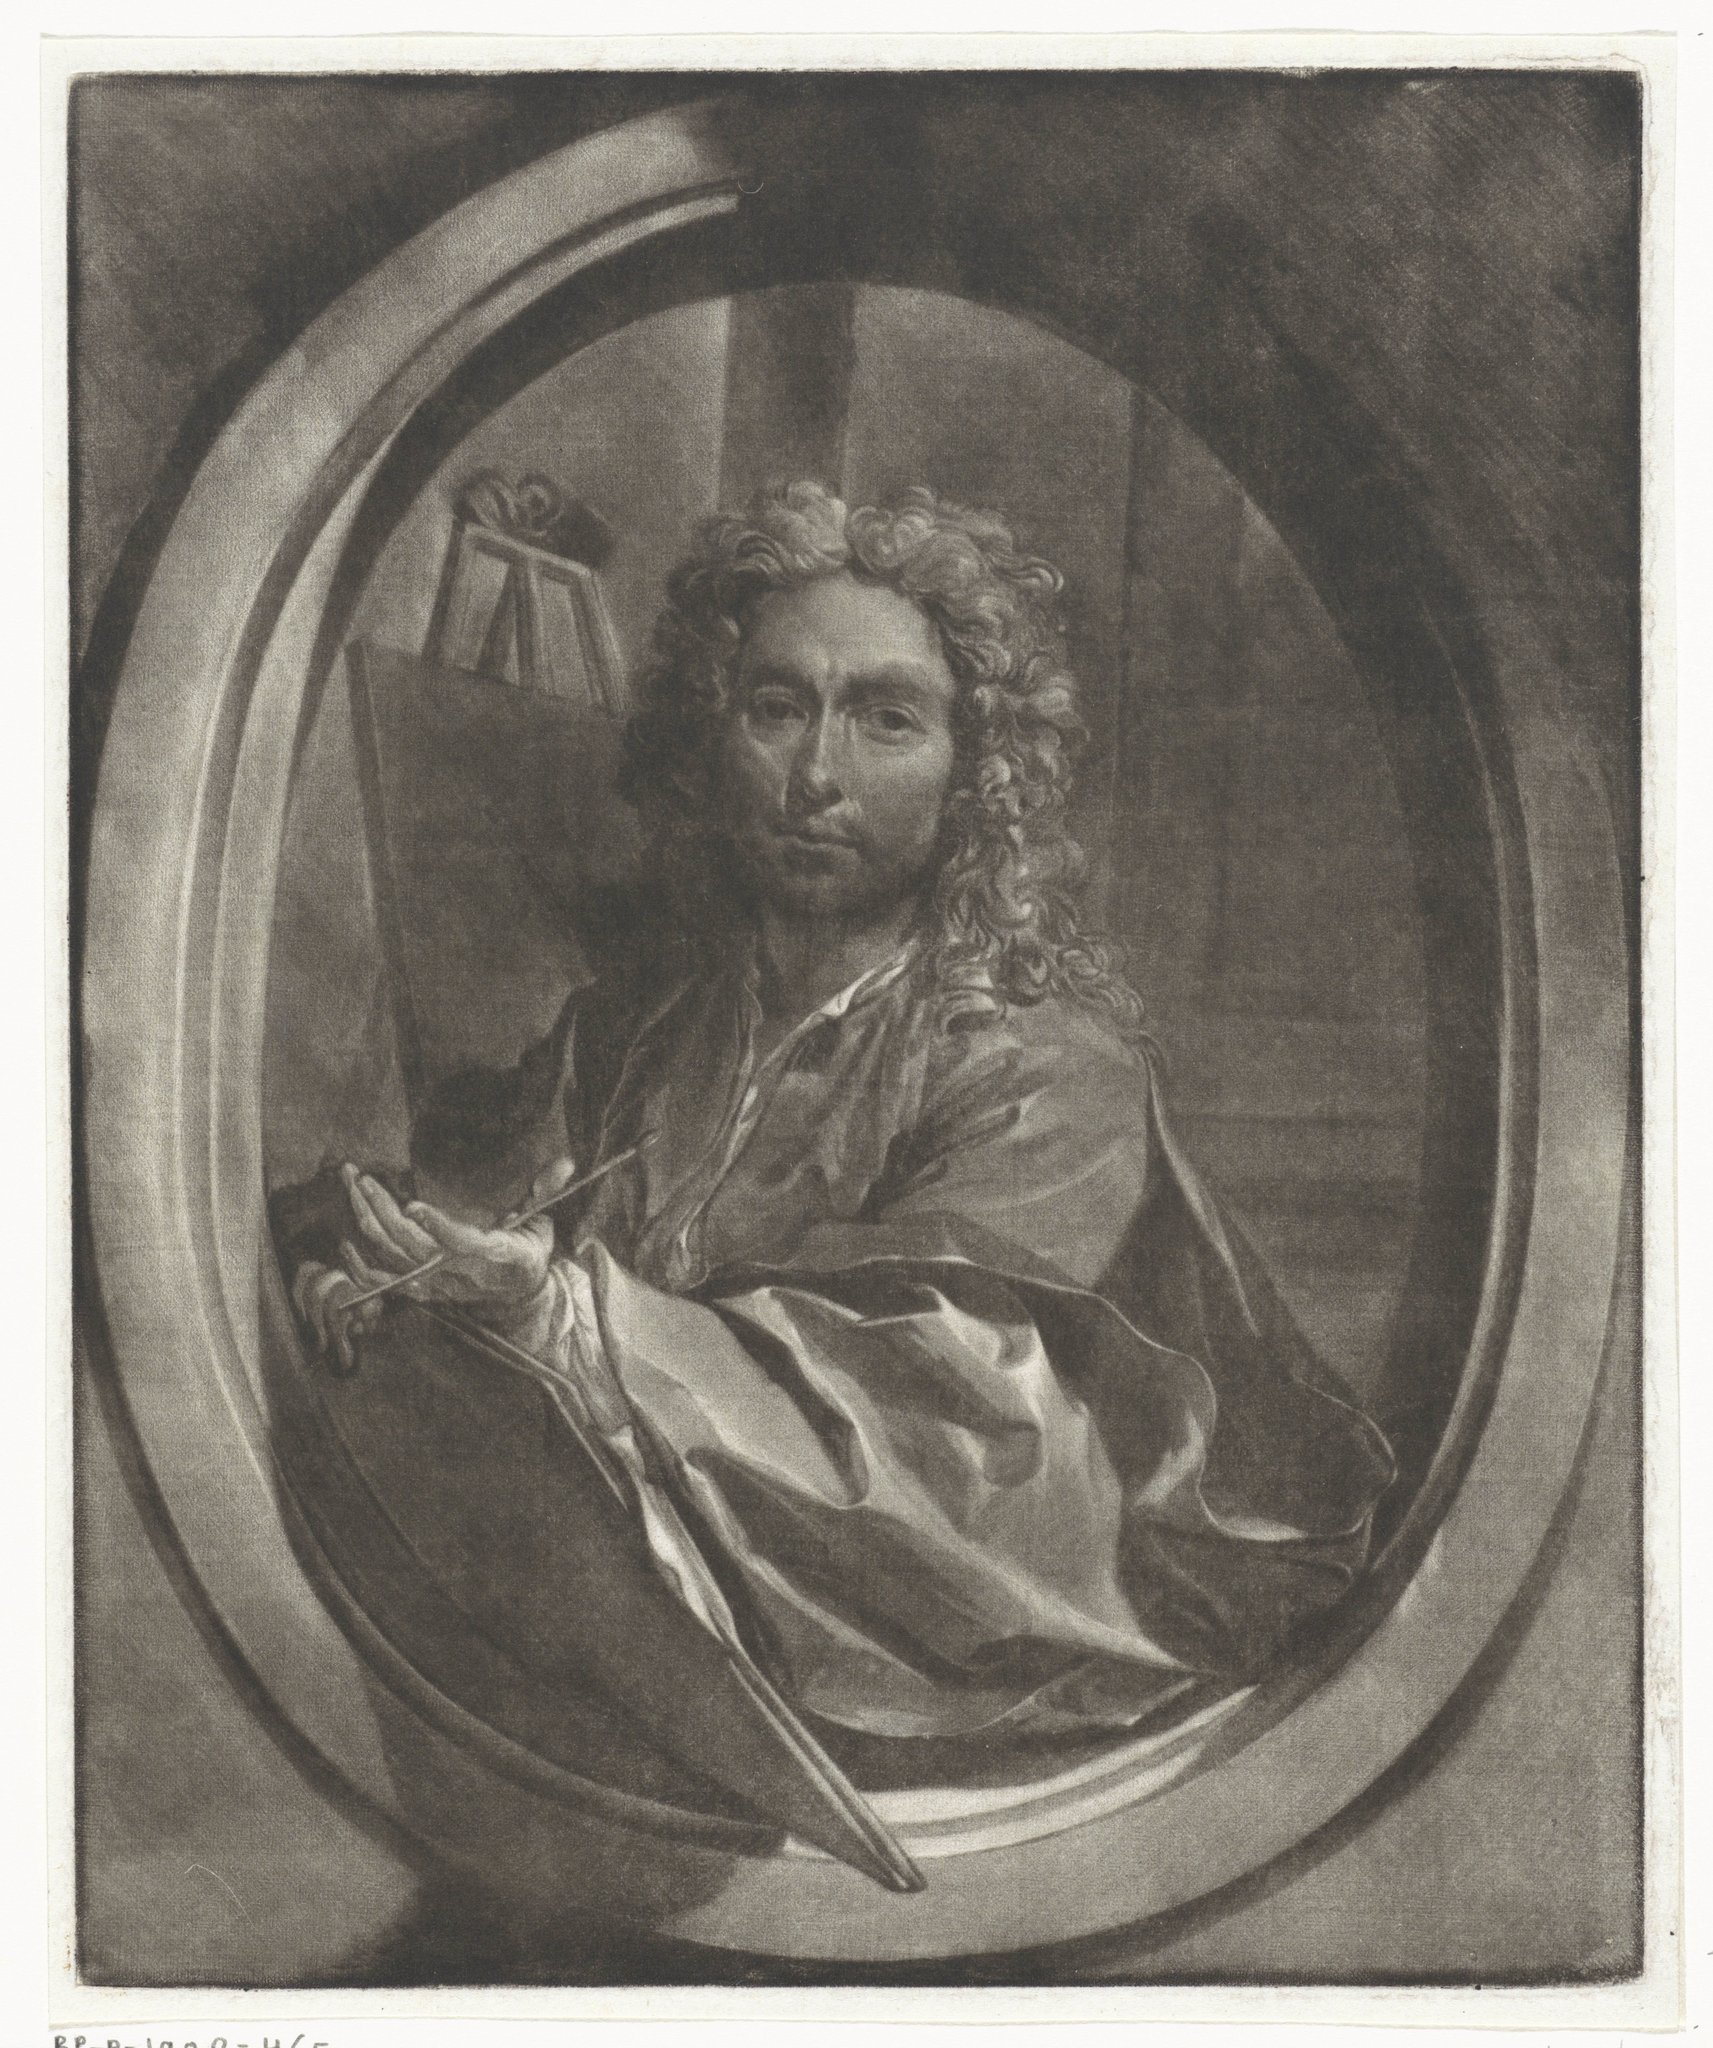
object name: print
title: Portret van Nicolaas Verkolje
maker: arnout rentinck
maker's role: draughtsman, print maker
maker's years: 1712-1774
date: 1753-1763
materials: paper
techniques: mezzotint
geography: amsterdam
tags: delft, amsterdam, painter, print maker, draughtsman, nicolaas verkolje, portrait, self-portrait of painter, tools, implements of painter, wig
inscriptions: collector's mark: Lugt 2228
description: De schilder, tekenaar en prentmaker Nicolaas Verkolje met een penseel en een portefeuille. Op de achtergrond een schildersezel.